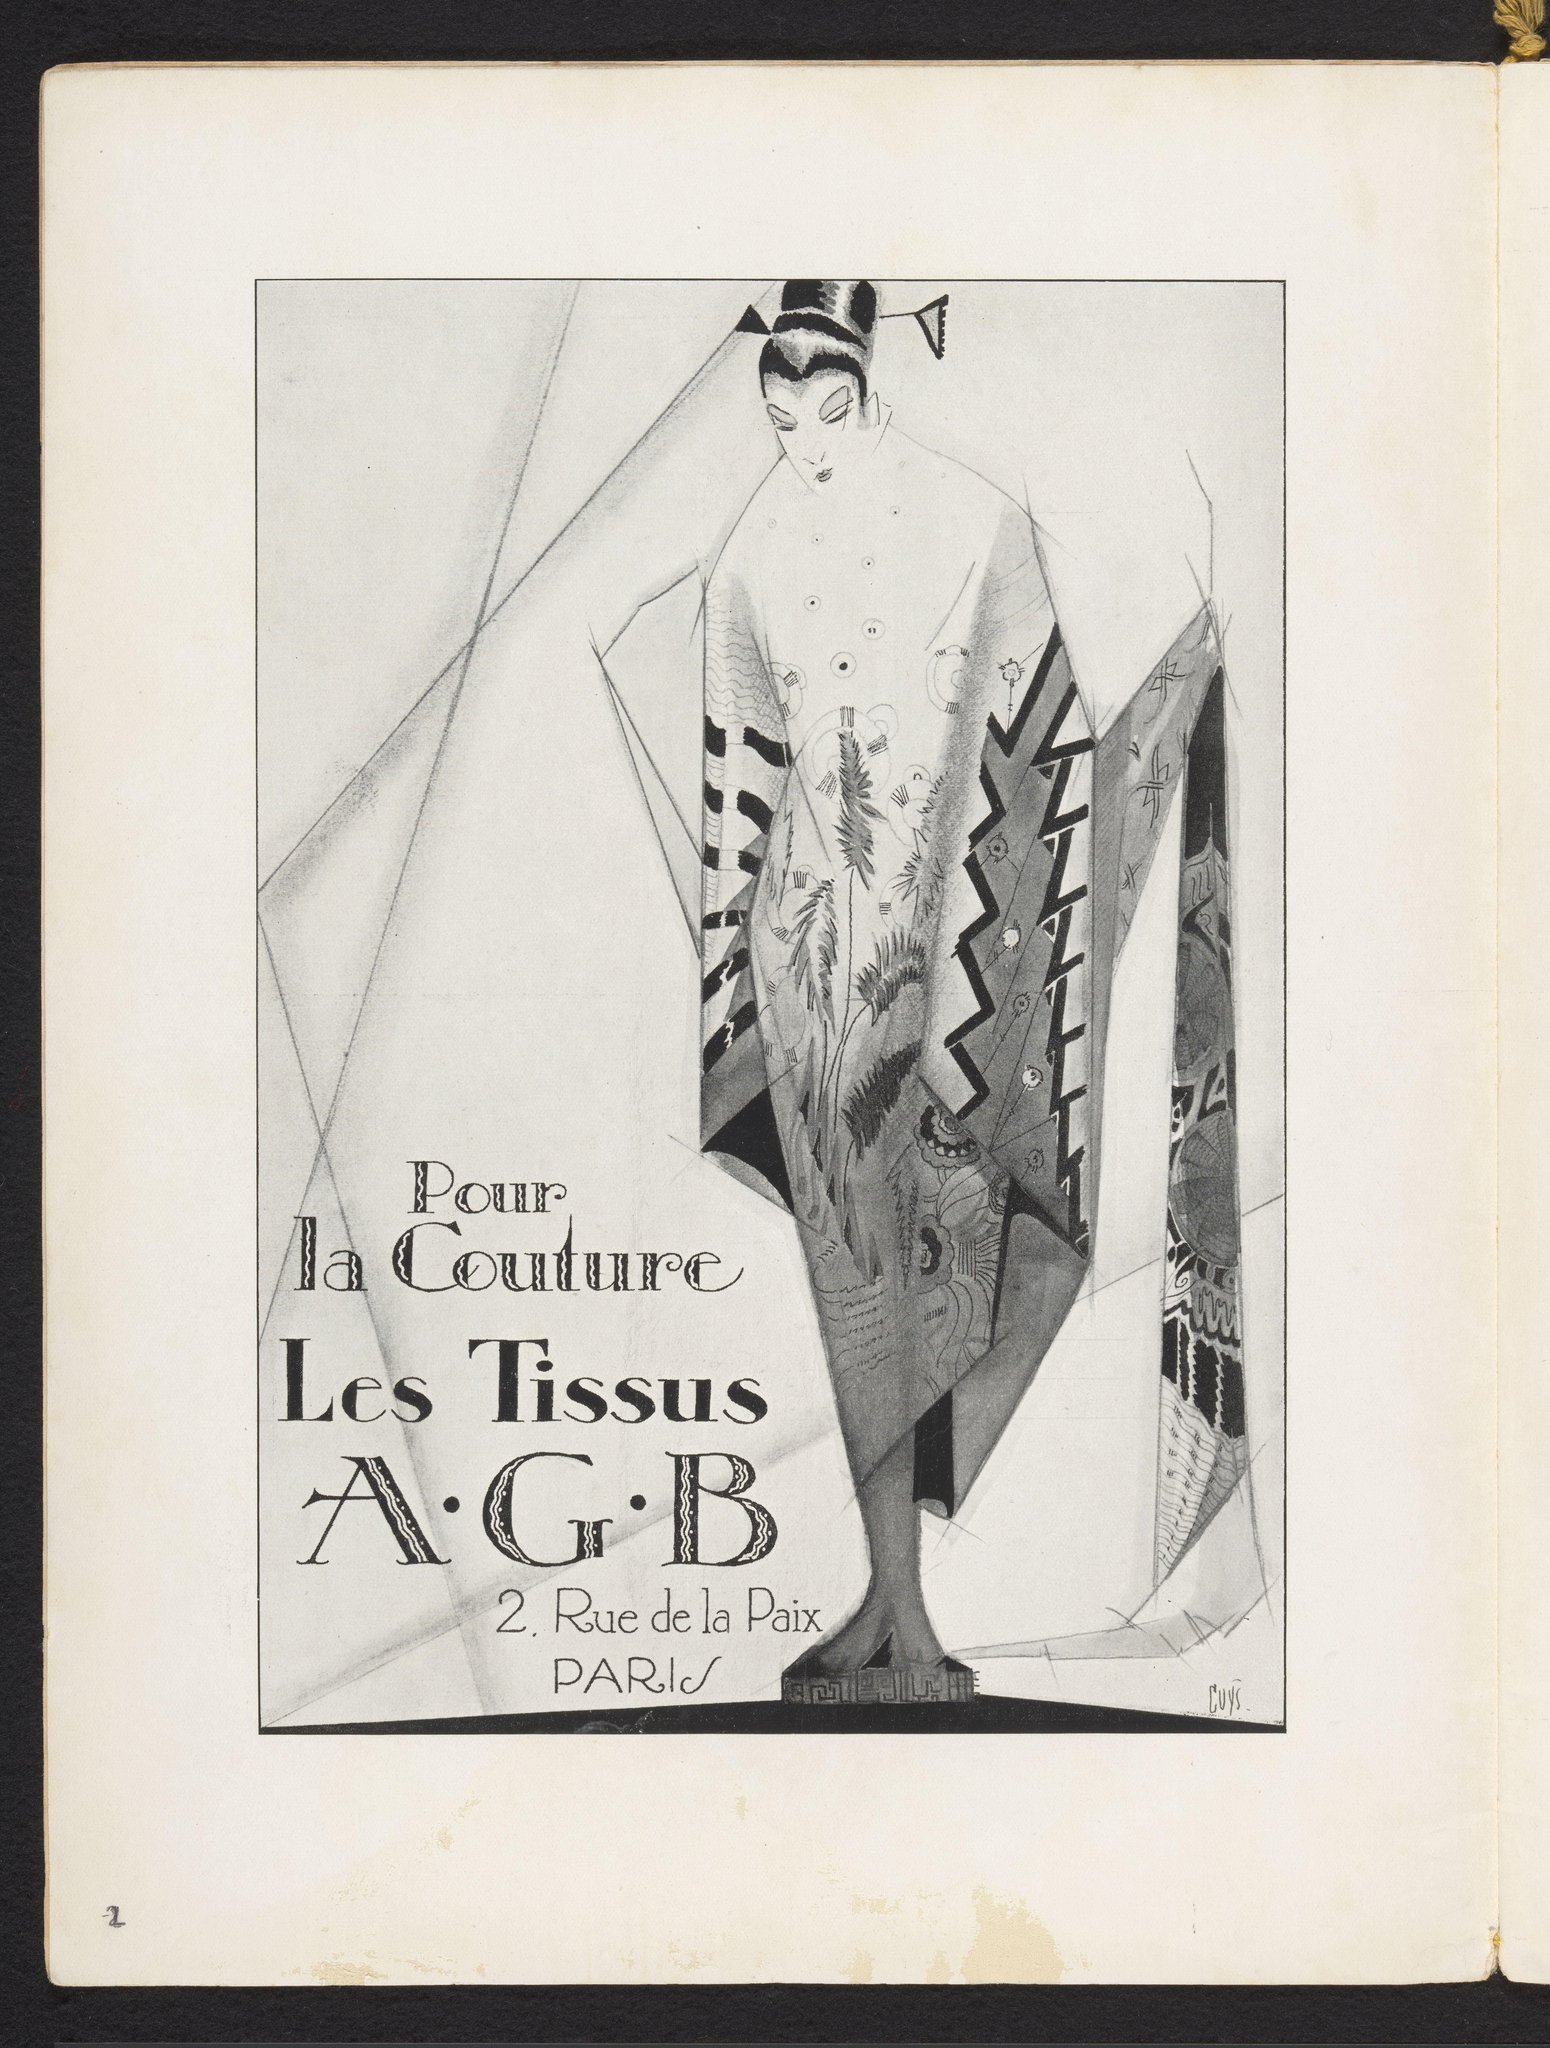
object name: magazine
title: Art - Goût - Beauté, Feuillets de l' élégance féminine, Février 1926, No. 66, 6e Année, p. 2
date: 1926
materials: paper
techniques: photography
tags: fashion plates, weaving-loom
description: Advertentie voor stoffen van de stoffenfabrikant ´Les Tissus A.G.B.´. Pagina uit het modetijdschrift Art-Goût-Beauté (1920-1933).